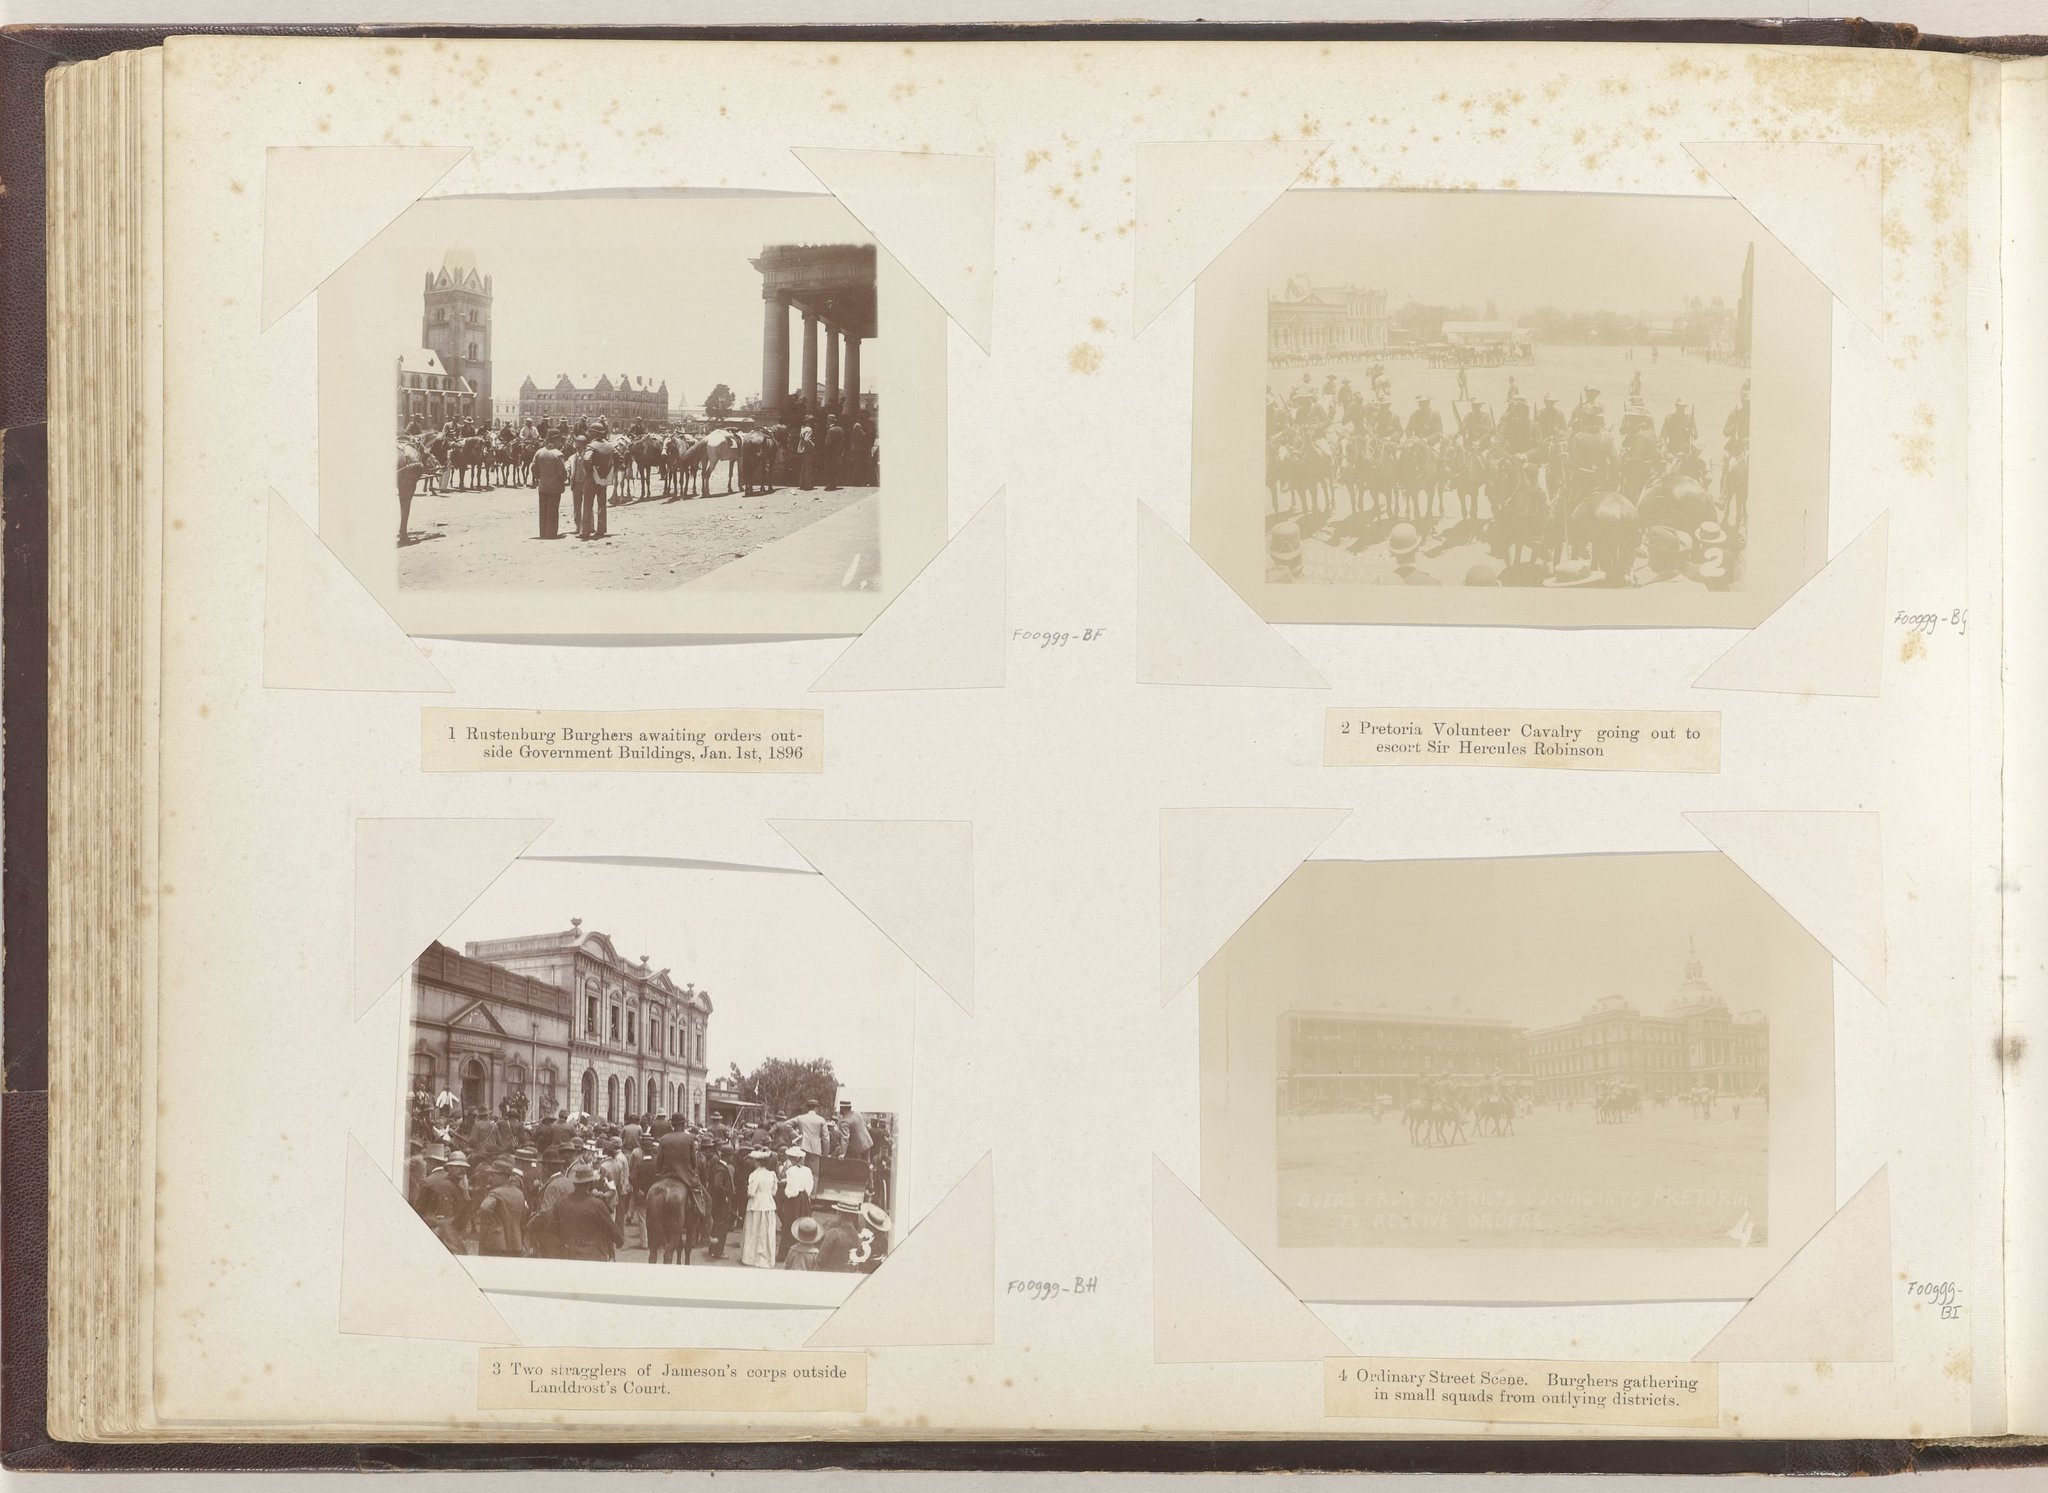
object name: photograph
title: Gewapende Boeren te paard in een straat in Pretoria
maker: Anonymous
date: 1896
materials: paper, photographic support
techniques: gelatin silver print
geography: pretoria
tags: land forces (+ cavalry, horsemen)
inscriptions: inscription: ‘Boers from districts coming in to Pretoria to receive orders. 4’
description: Onderdeel van Album met 191 foto's van een reis naar en door Zuid-Afrika.